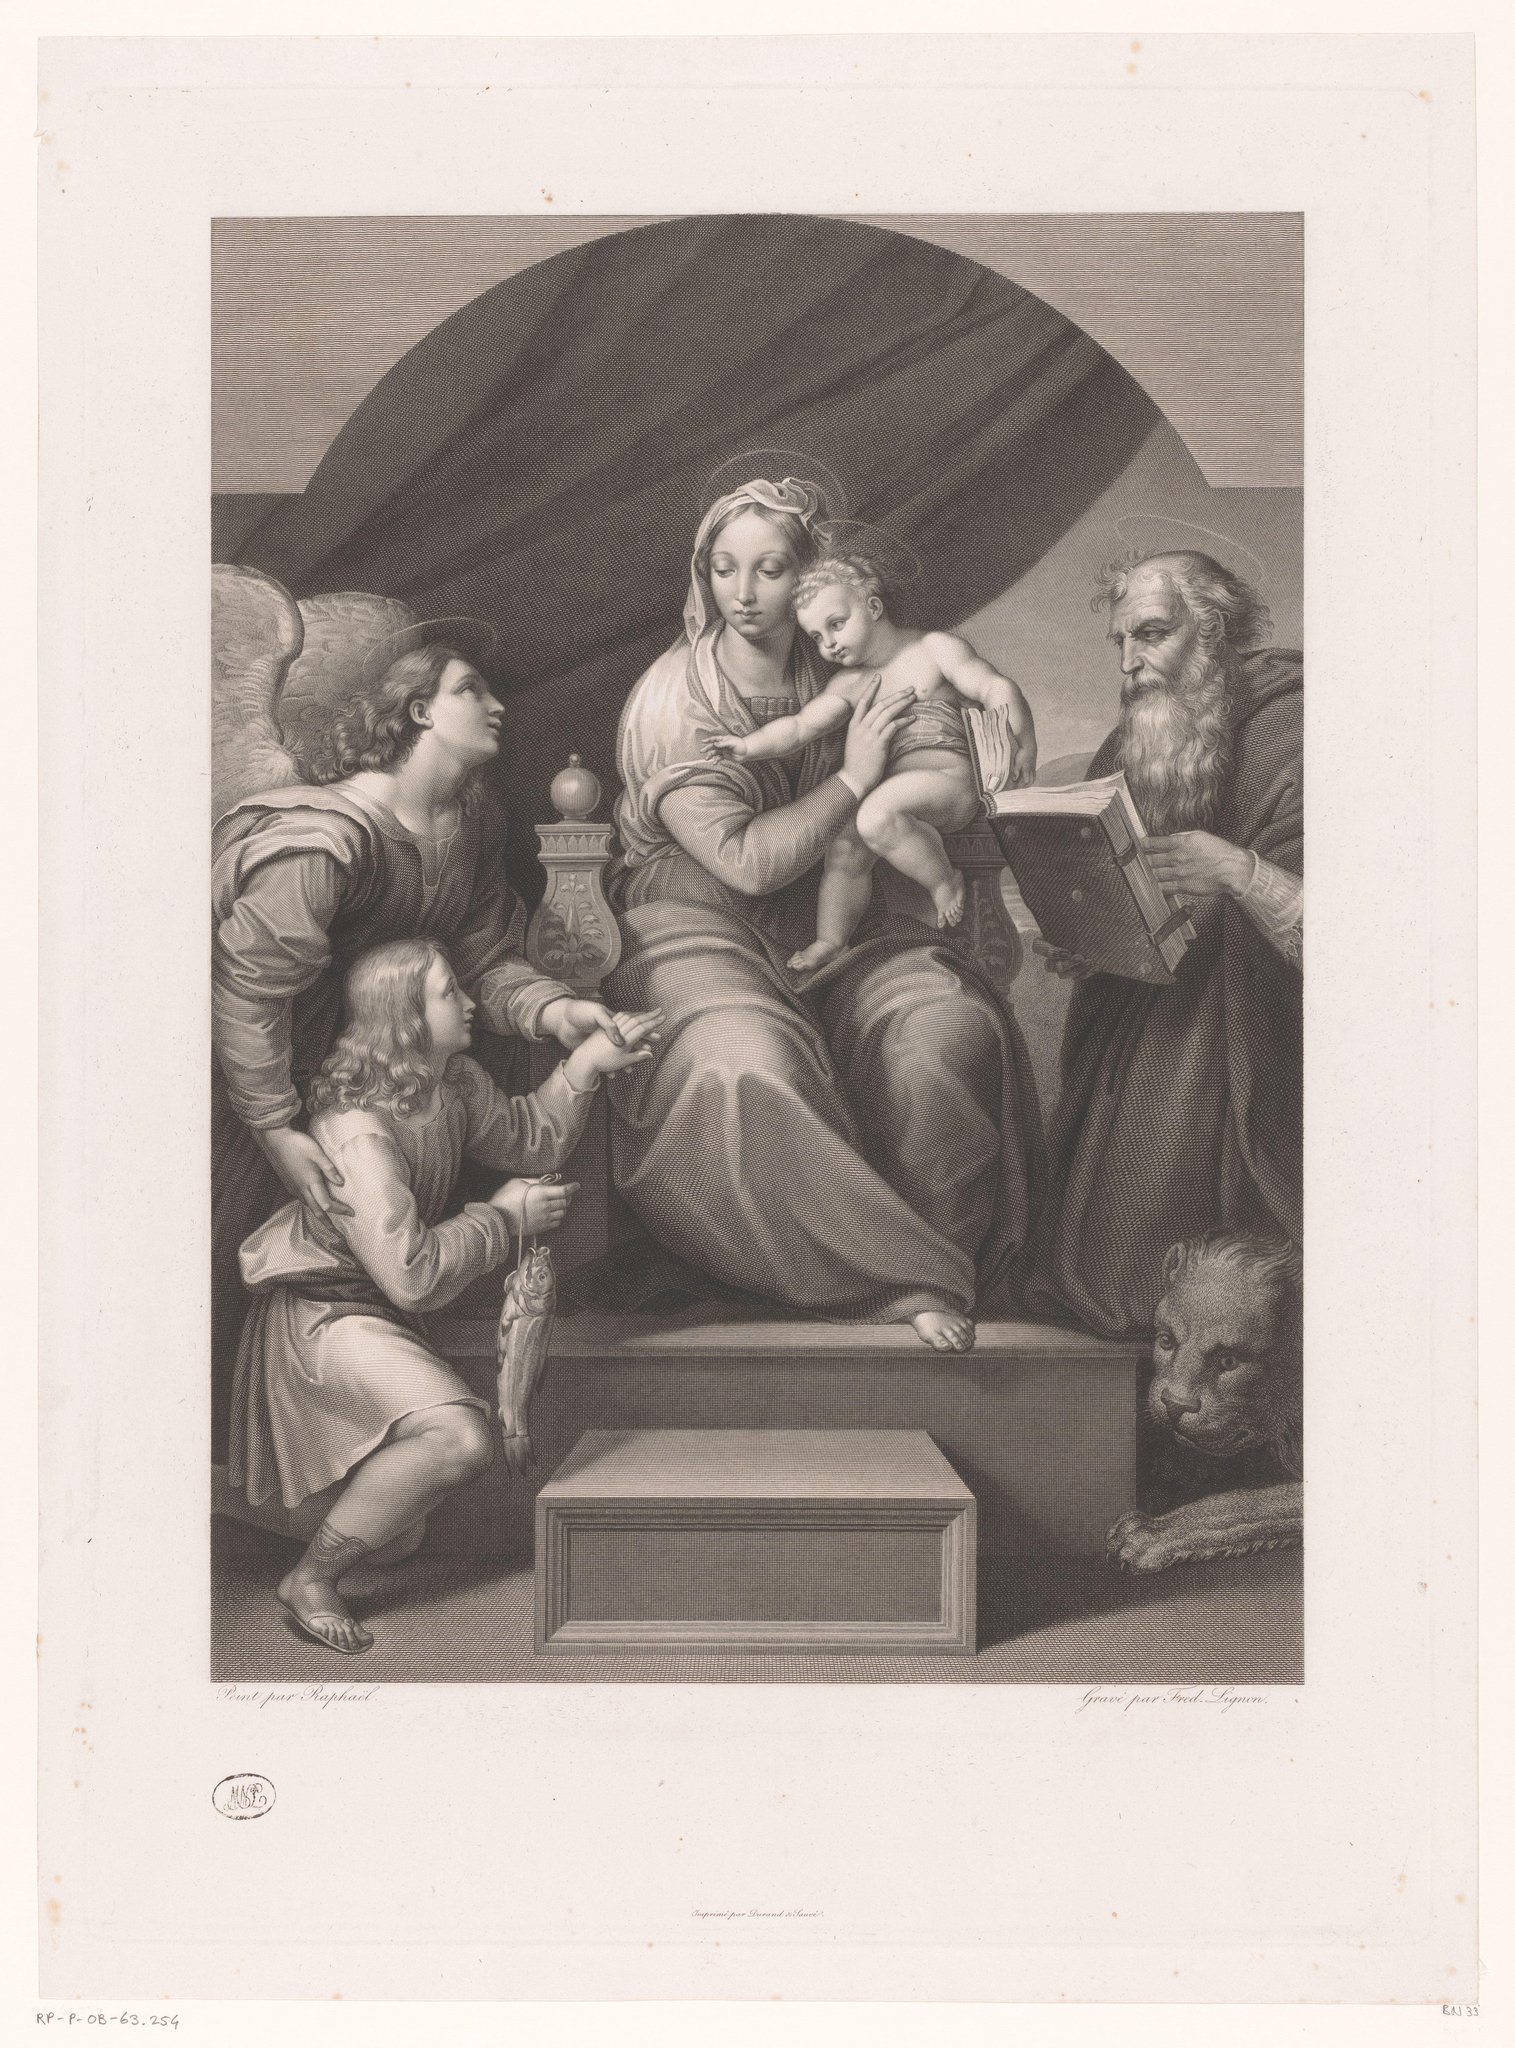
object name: print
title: Tobias en de engel bij Maria met kind en de H. Hieronymus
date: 1822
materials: paper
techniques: engraving, etching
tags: madonna: i.e. mary with the christ-child, story of tobias: tobias and sarah (tobit 7-9), the monk and hermit jerome (hieronymus); possible attributes: book, cardinal's hat, crucifix, hour-glass, lion, skull, stone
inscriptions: collector's mark: Lugt 1901, collector's mark: Lugt 12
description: Het schilderij bevindt zich in de collectie van het Muséo del Prado, inv.nr. 297.